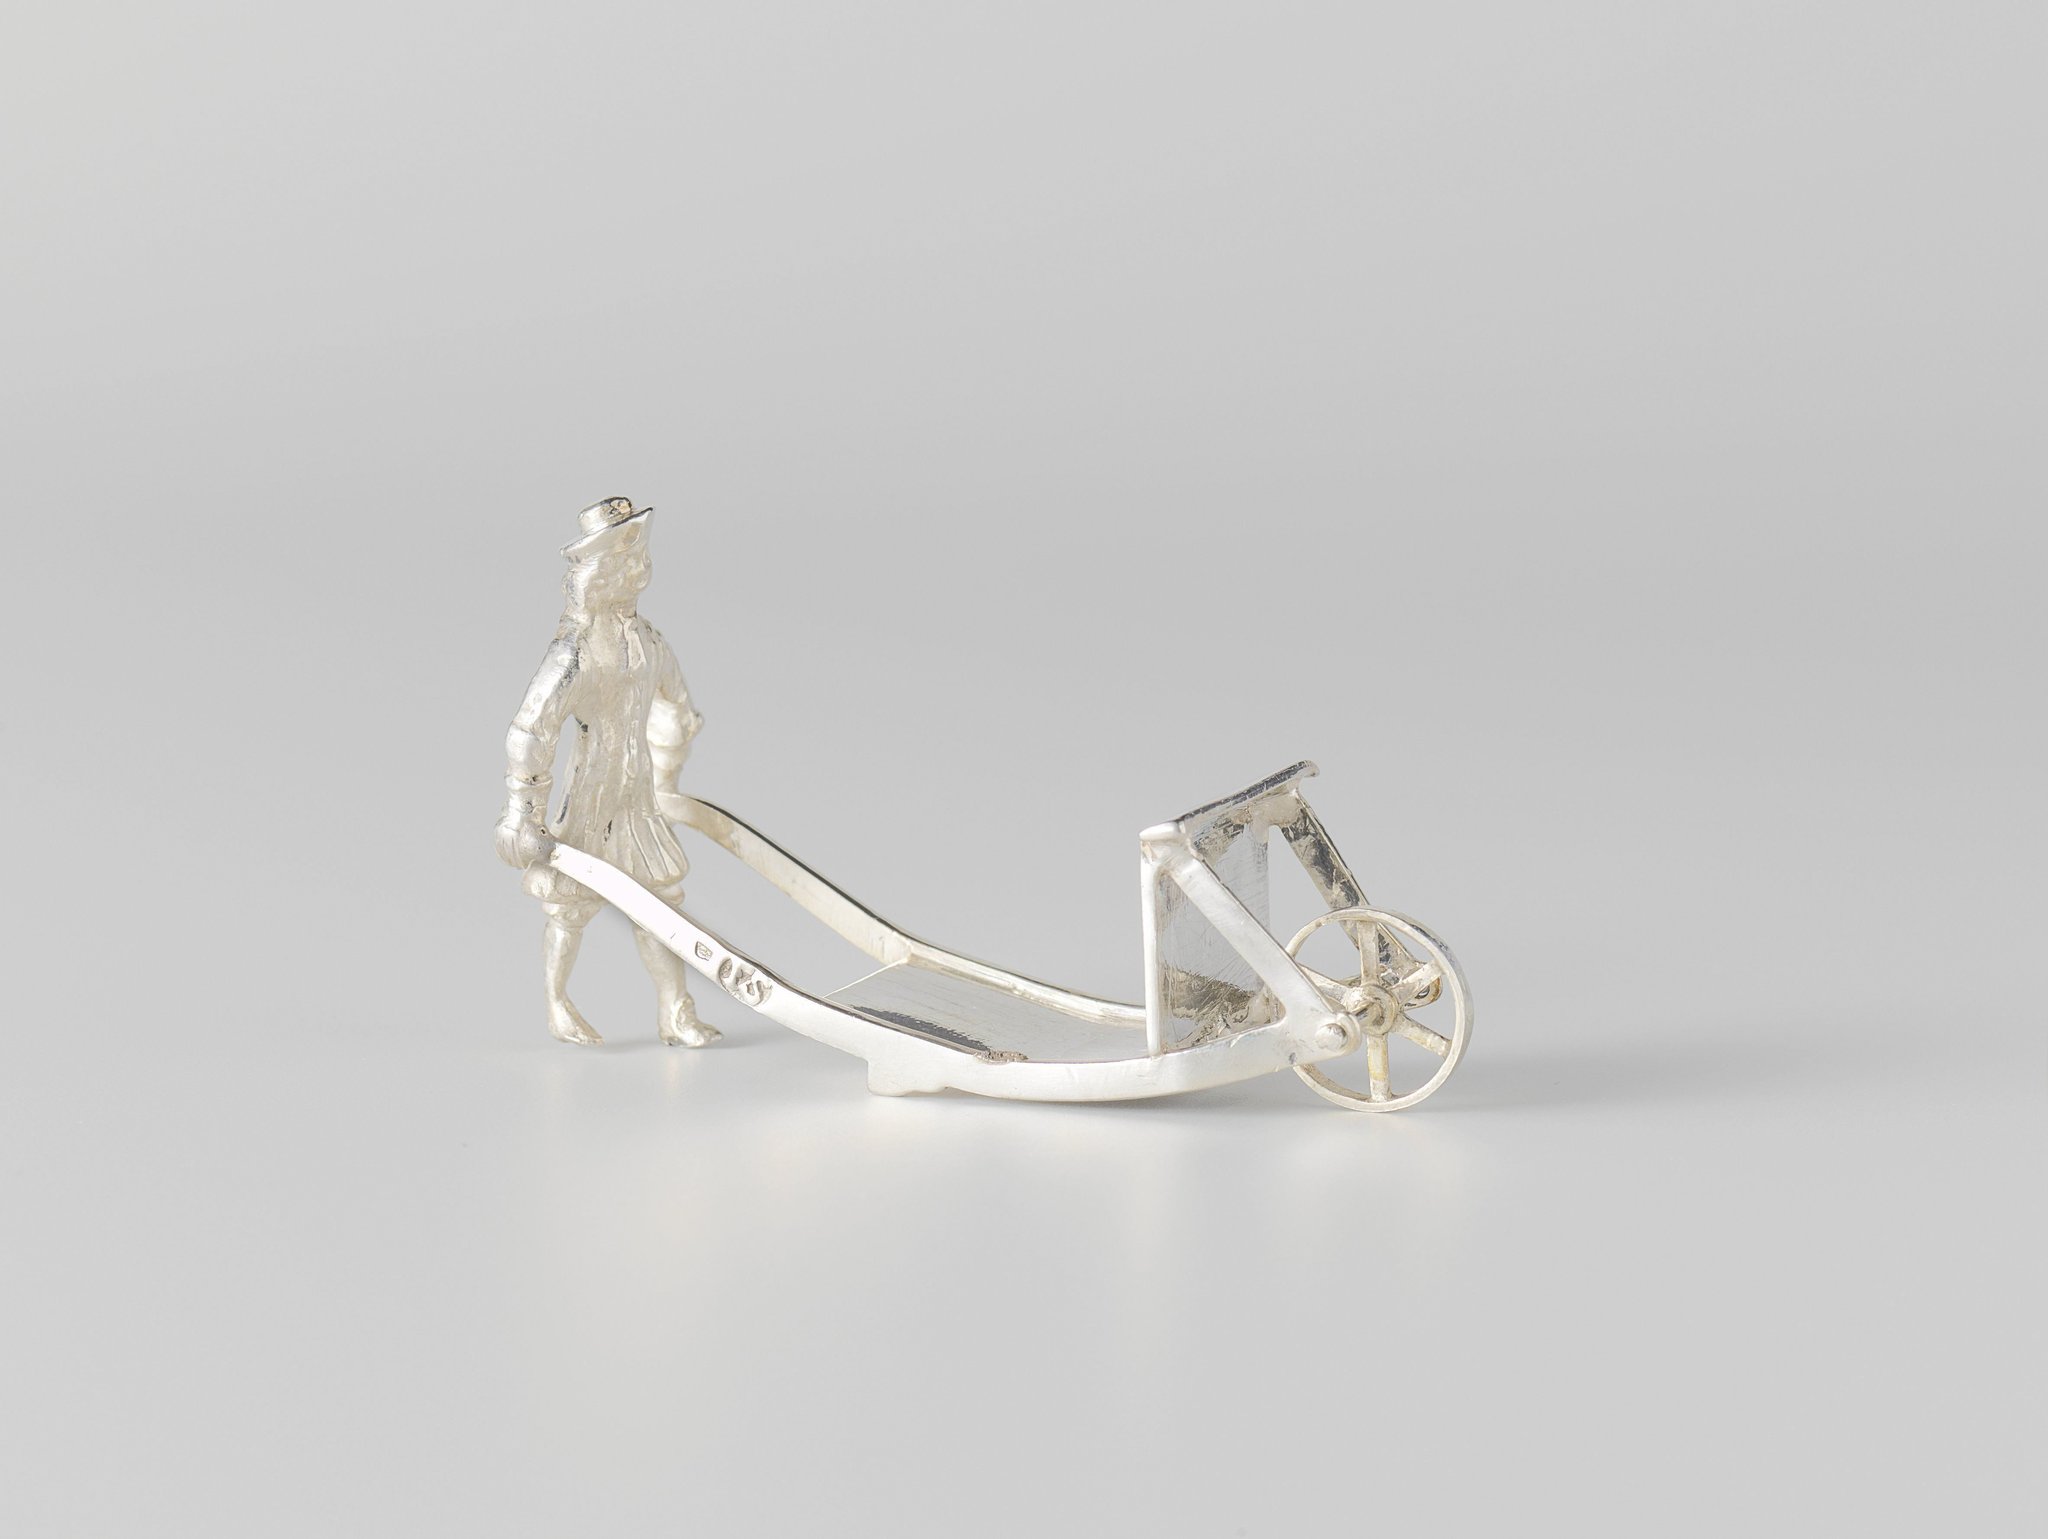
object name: miniature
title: Man met kruiwagen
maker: frederik van strant (i)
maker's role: silversmith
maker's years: 1678-1727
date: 1725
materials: silver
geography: amsterdam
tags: wheelbarrow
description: Platte kruiwagen met twee lange handvatten. De kruiwagen wordt voortgeduwd door een man met een hoed. Het beeld is gemerkt: mt.= toegeschreven aan Frederik van Strant I en een zwijnskop.